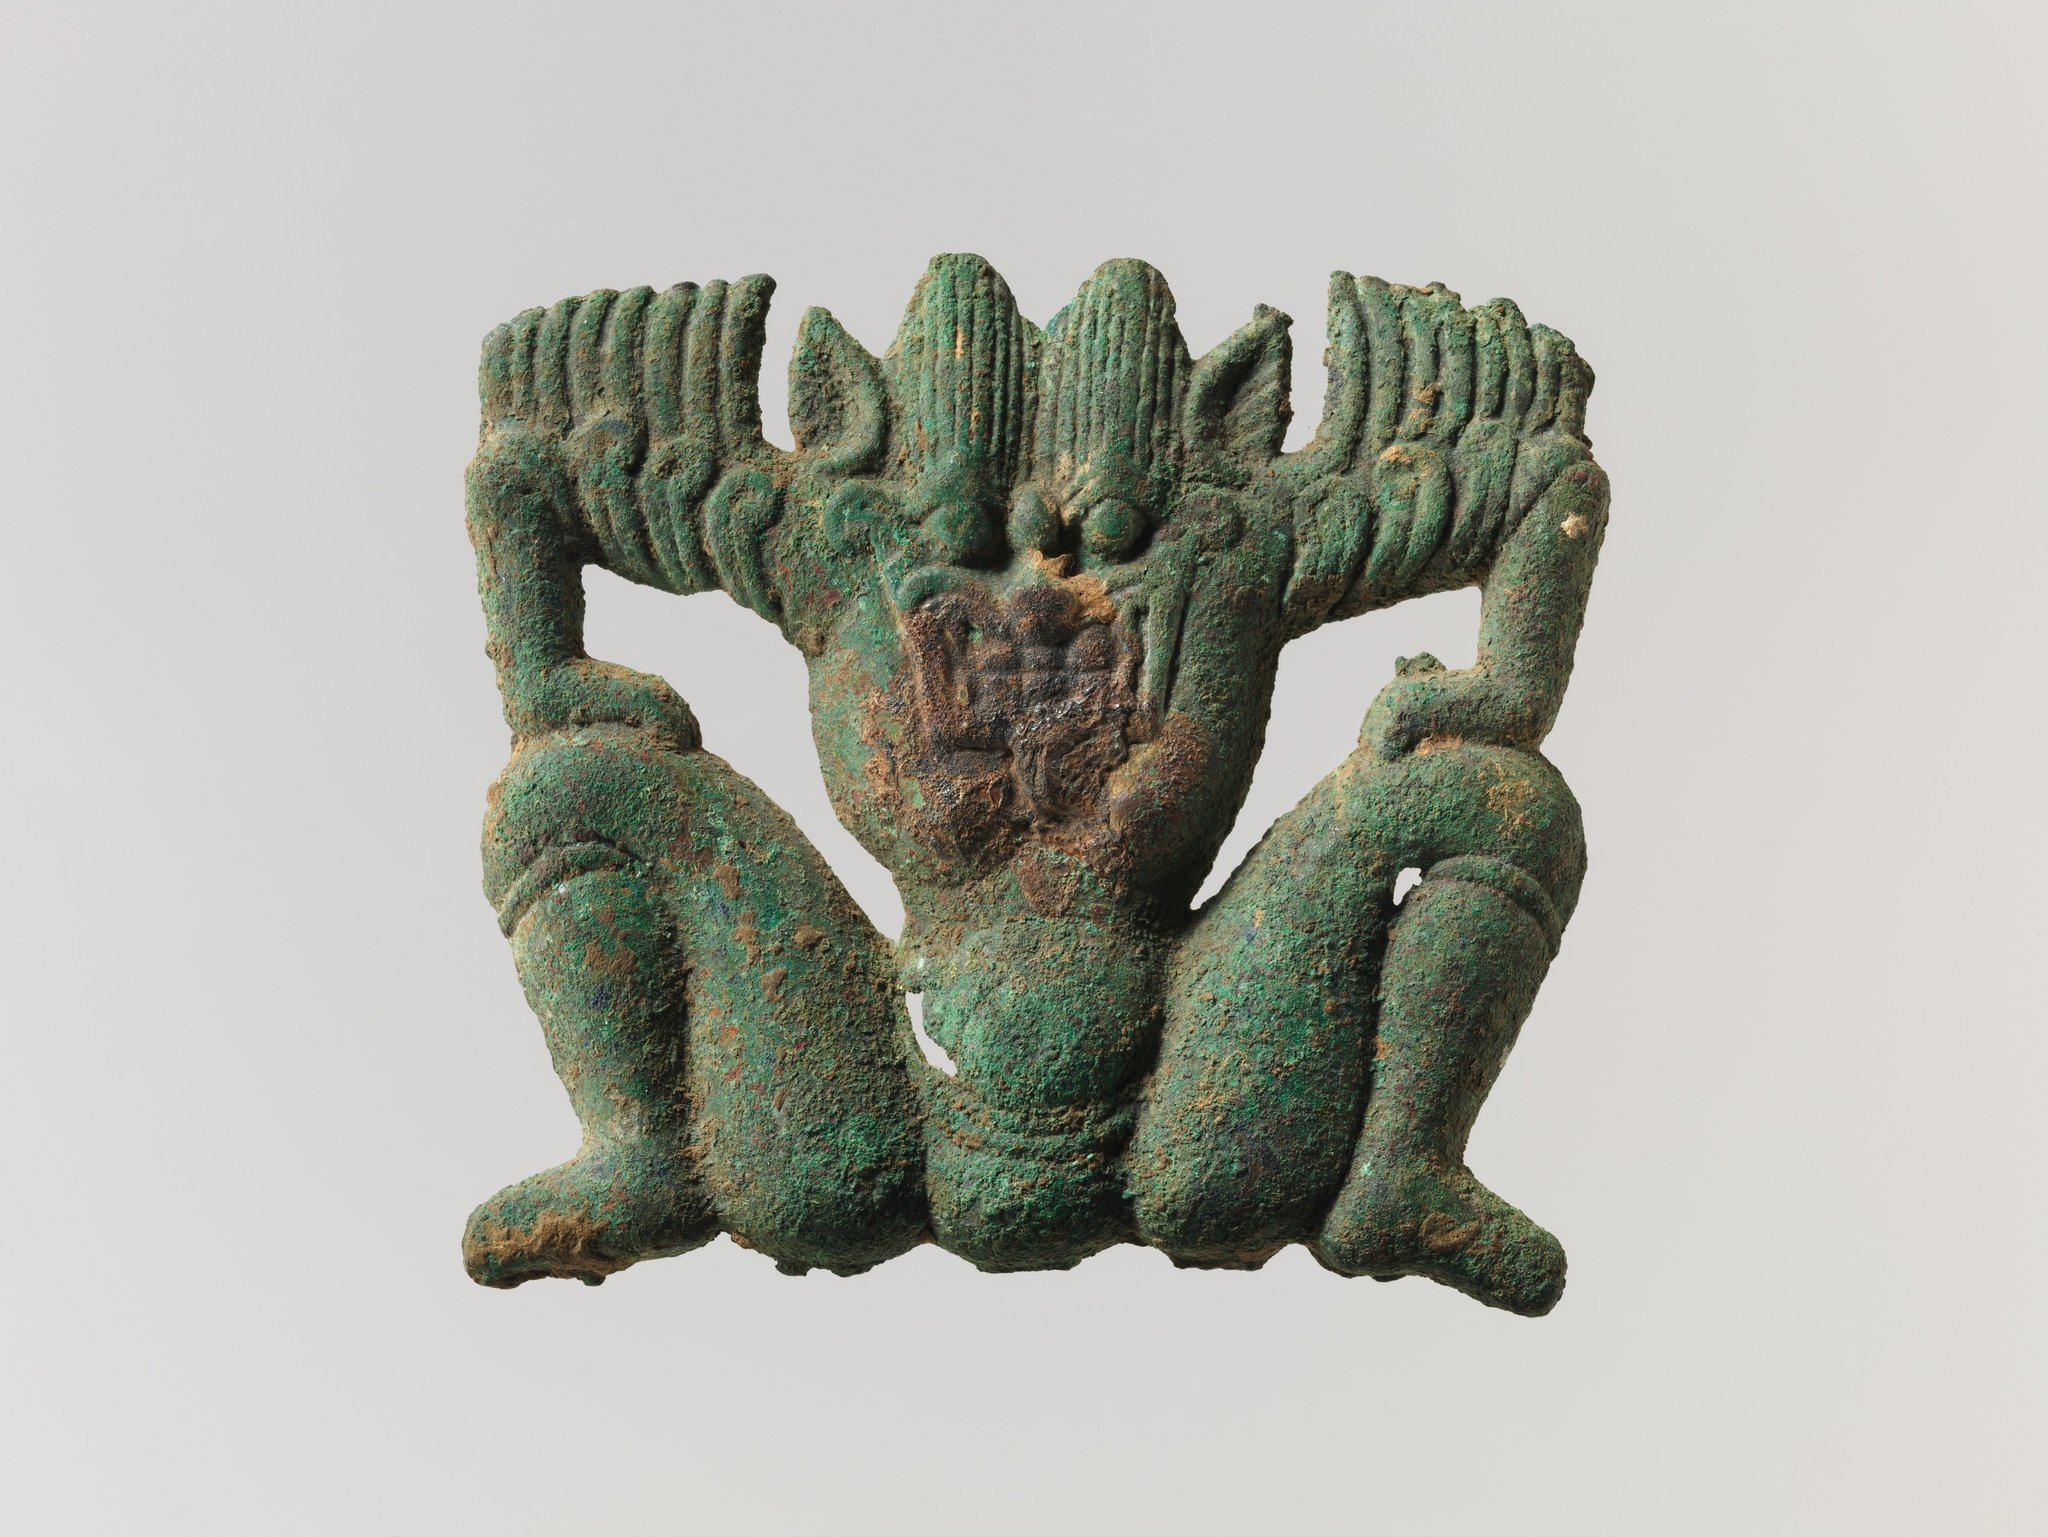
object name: plaque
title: Plaque in the Form of a Demon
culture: chinese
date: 25-220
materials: bronze, iron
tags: demons